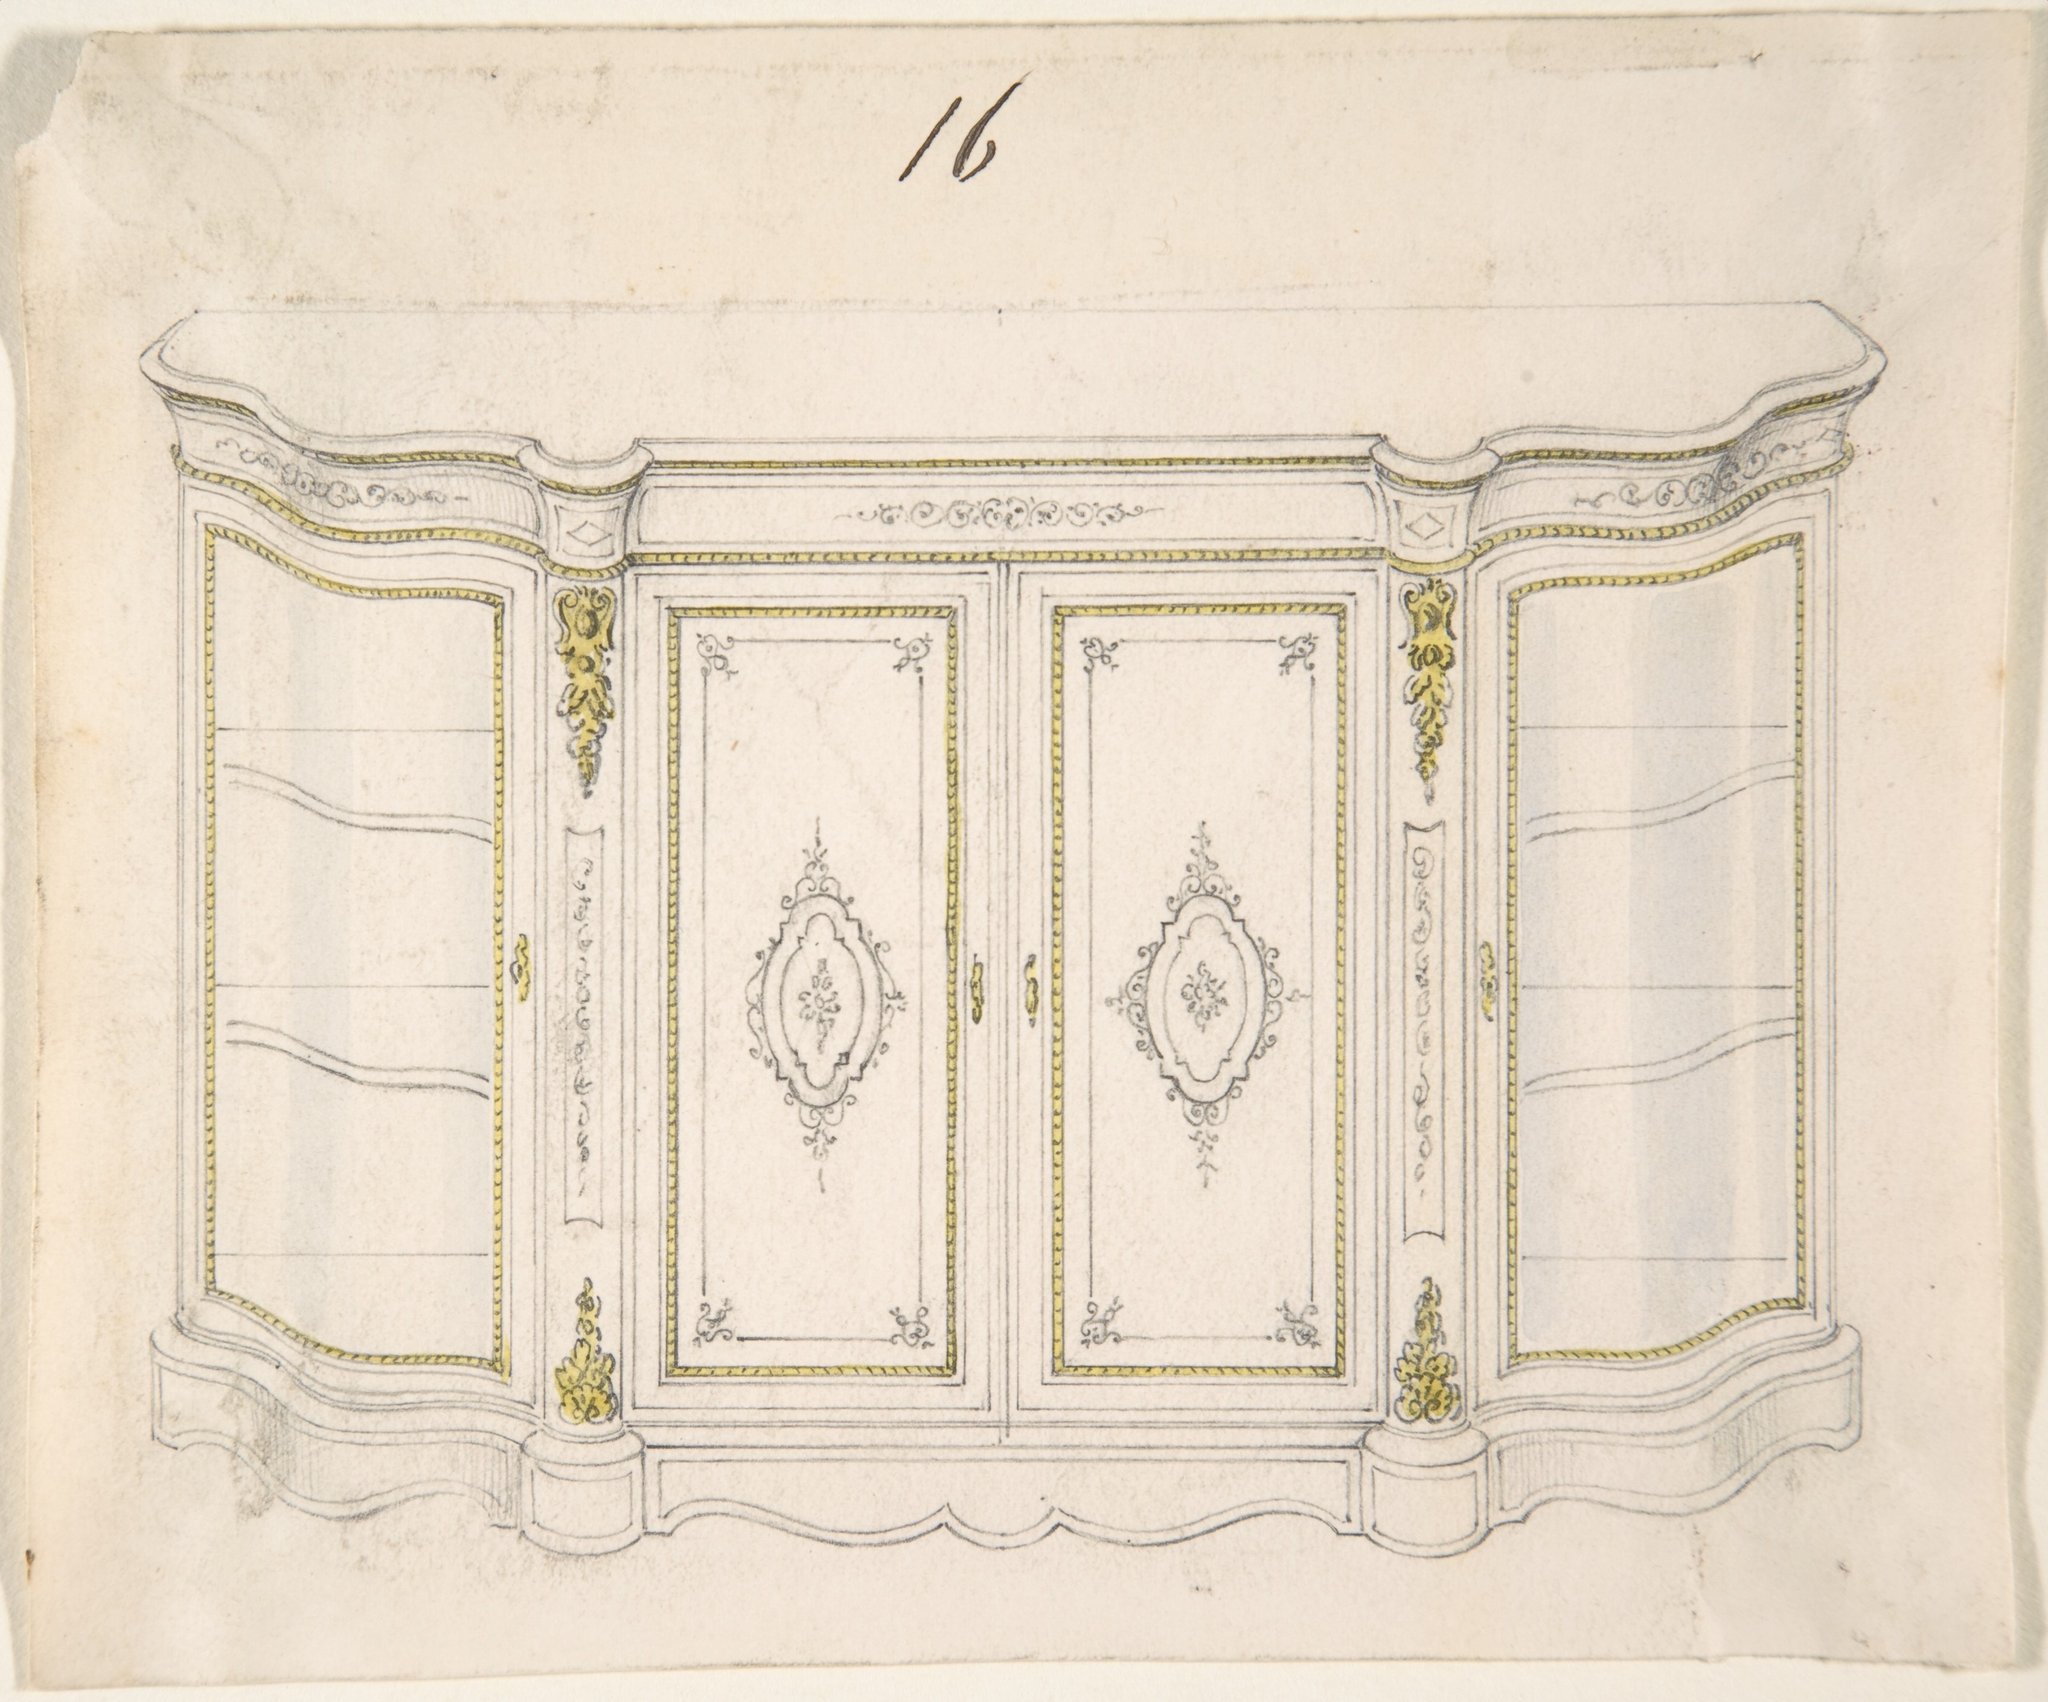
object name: drawing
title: Cabinet Design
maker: anonymous, british, 19th century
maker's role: artist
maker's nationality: british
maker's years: 1800-1900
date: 1801-1900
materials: ink, watercolor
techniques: pen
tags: cabinets